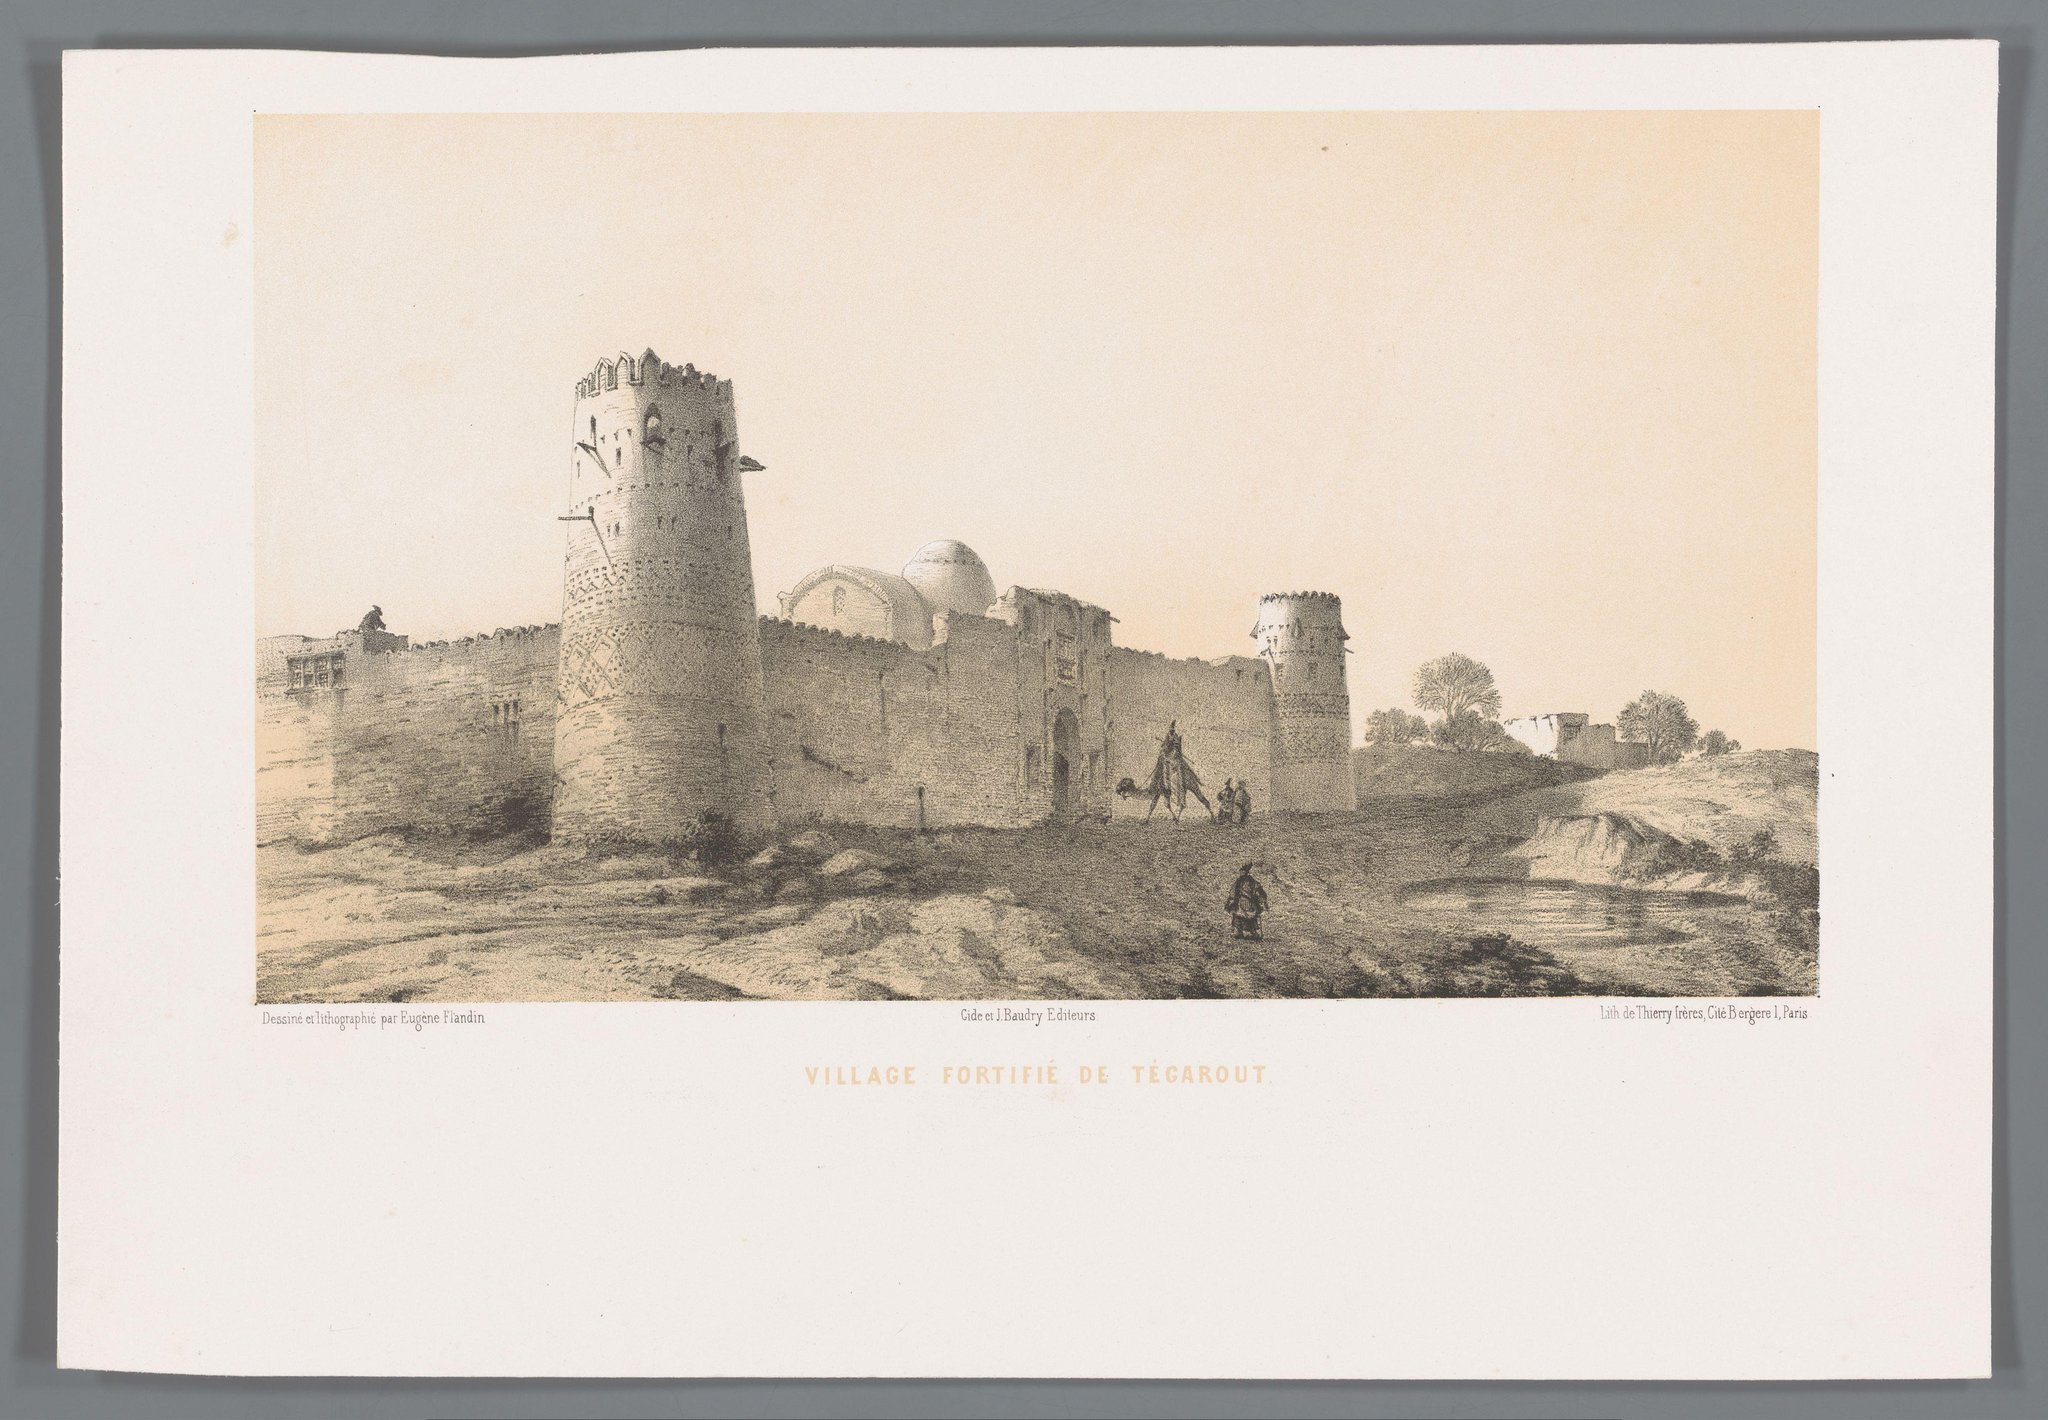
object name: print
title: Village fortifié de Tégarout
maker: eugène flandin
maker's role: painter, print maker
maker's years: 1809-1889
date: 1843-1854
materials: paper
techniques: tone lithography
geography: paris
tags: prospect of village, silhouette of village, village-walls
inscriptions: collector's mark: Lugt 2228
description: Prent uit: Coste, Pascal-Xavier en Eugène Napoléon Flandin. Voyage en Perse de mm. Eugène Flandin, peintre, et Pascal Coste, architecte (...). 8 dln. Parijs: Gide et Jules Baudry, 1843-1854.